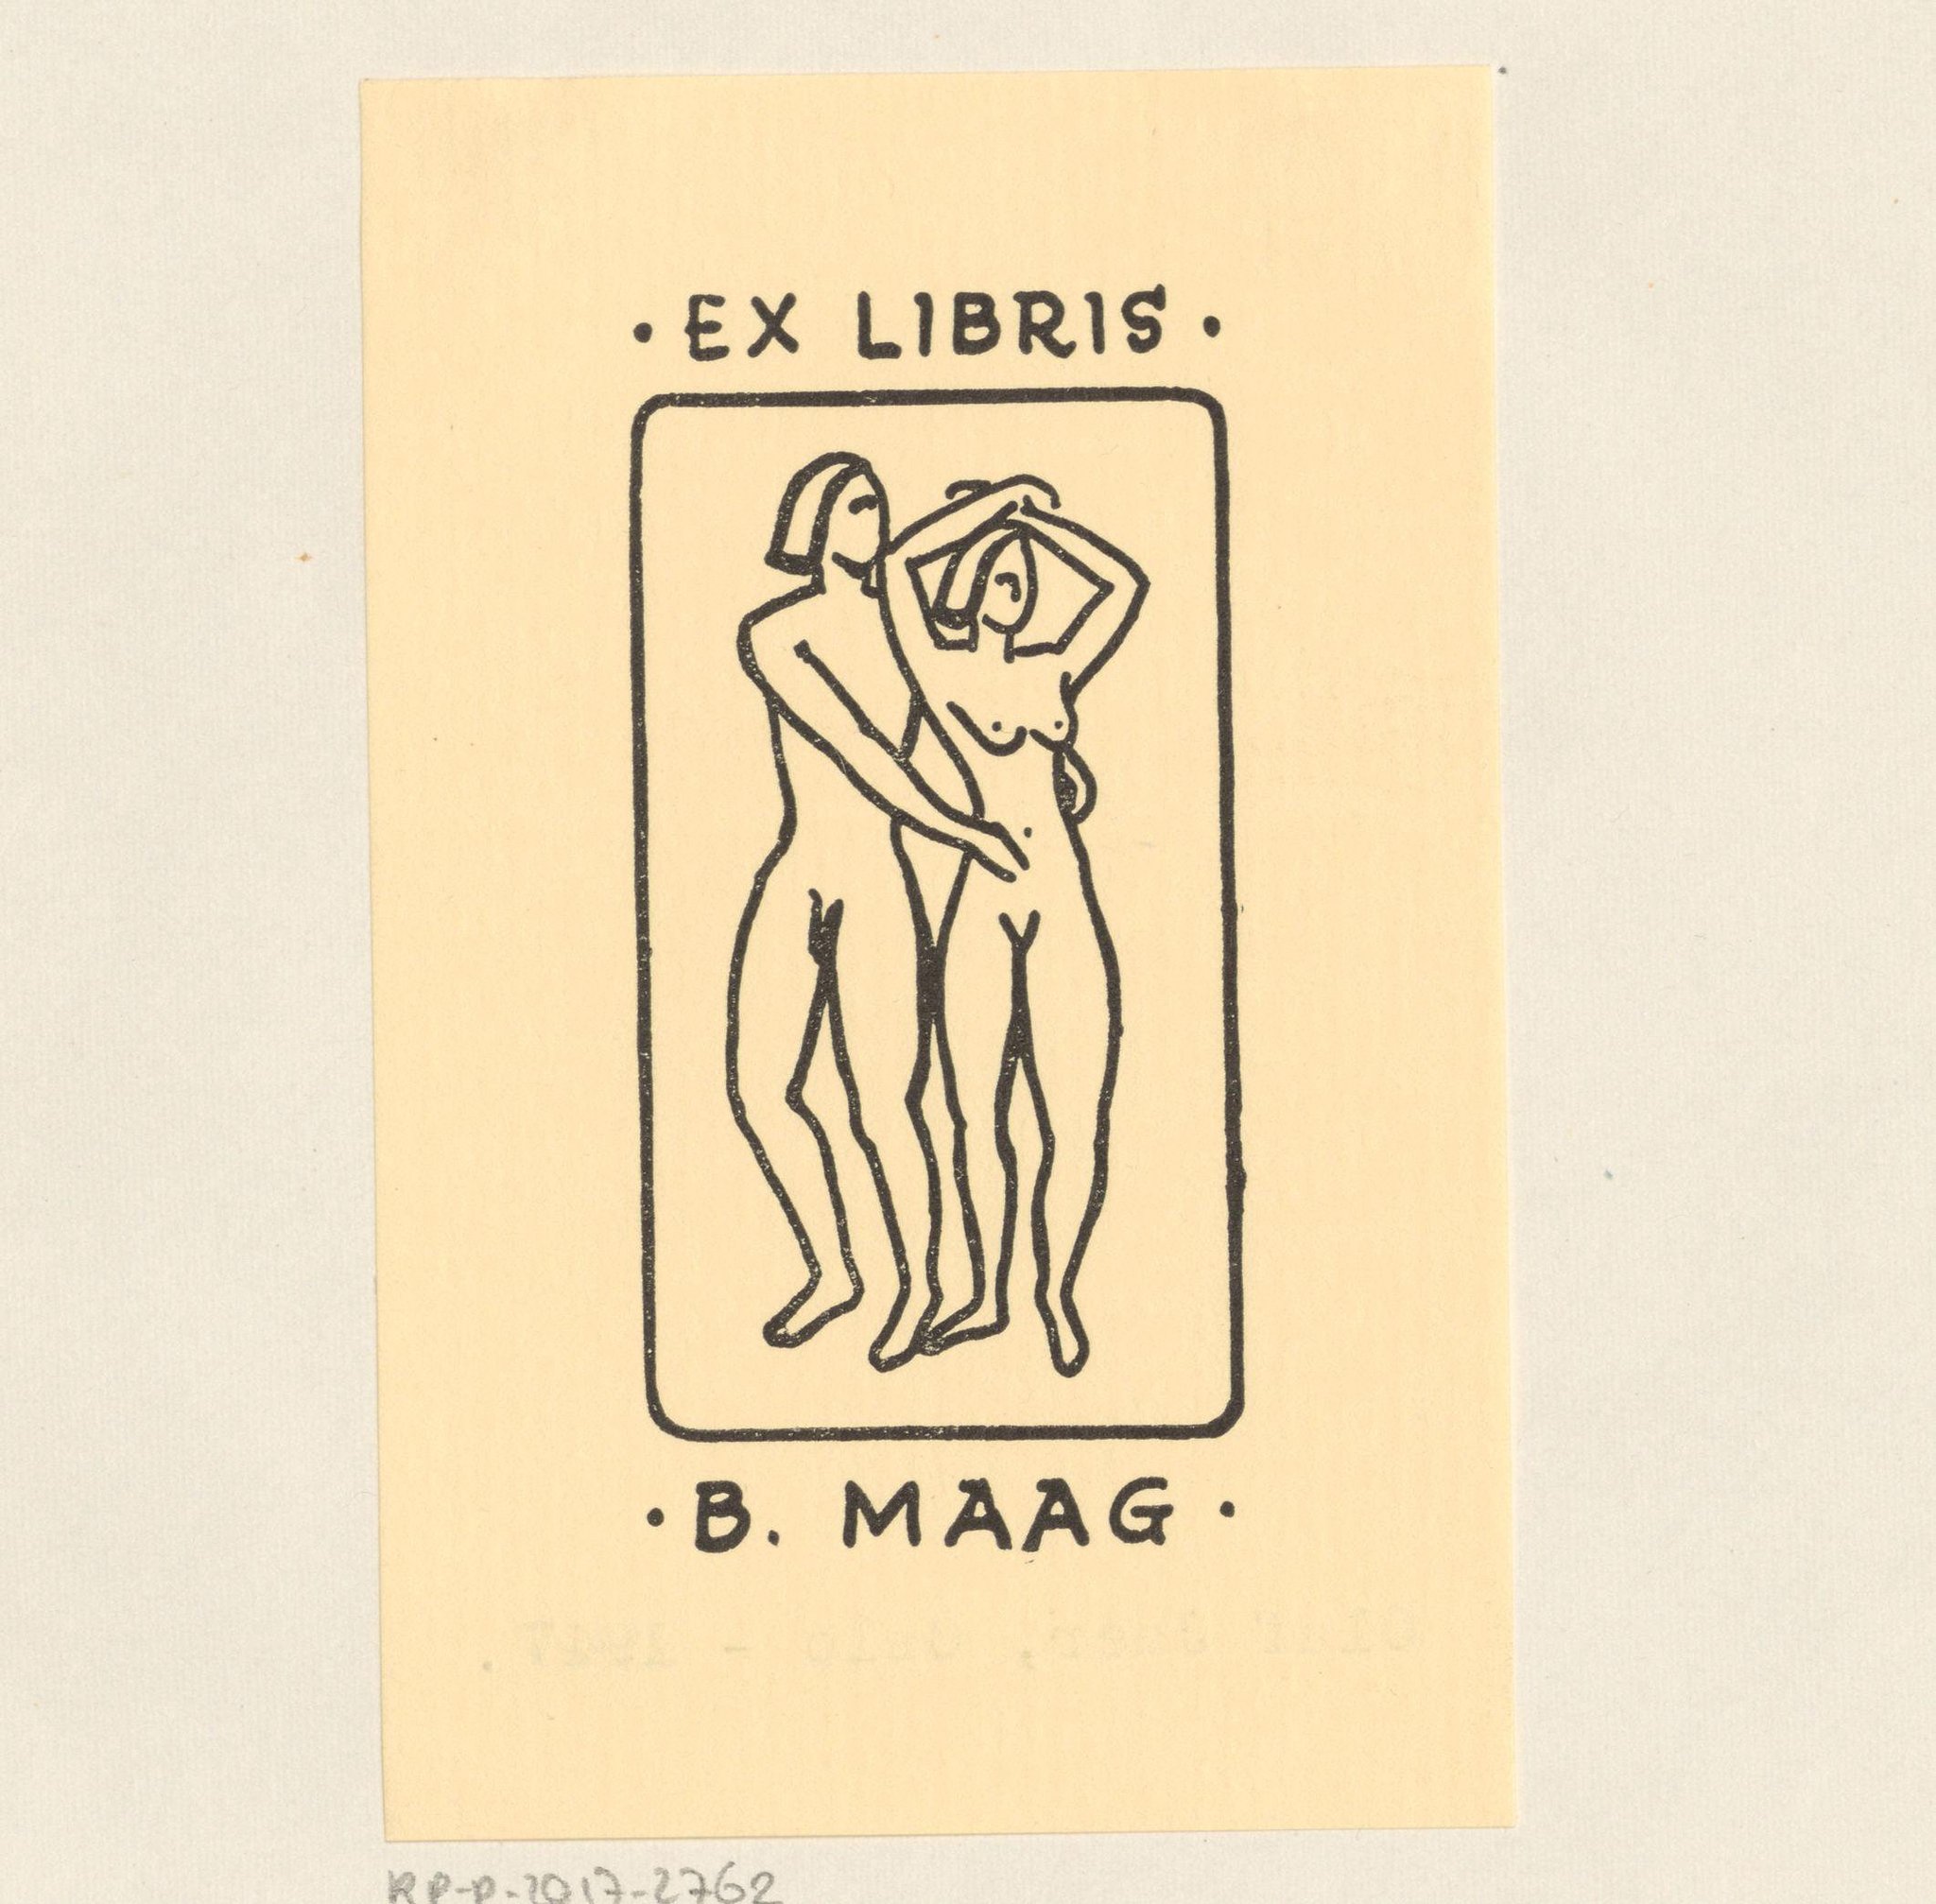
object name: bookplate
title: Ex libris van B. Maag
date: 1947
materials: paper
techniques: printing block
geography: norway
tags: woman (showing herself) undressed, quasi-nude, couple of lovers, man (showing himself) undressed, quasi-nude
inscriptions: workshop stamp: ‘Olaf Jaer, Oslo - 1947’